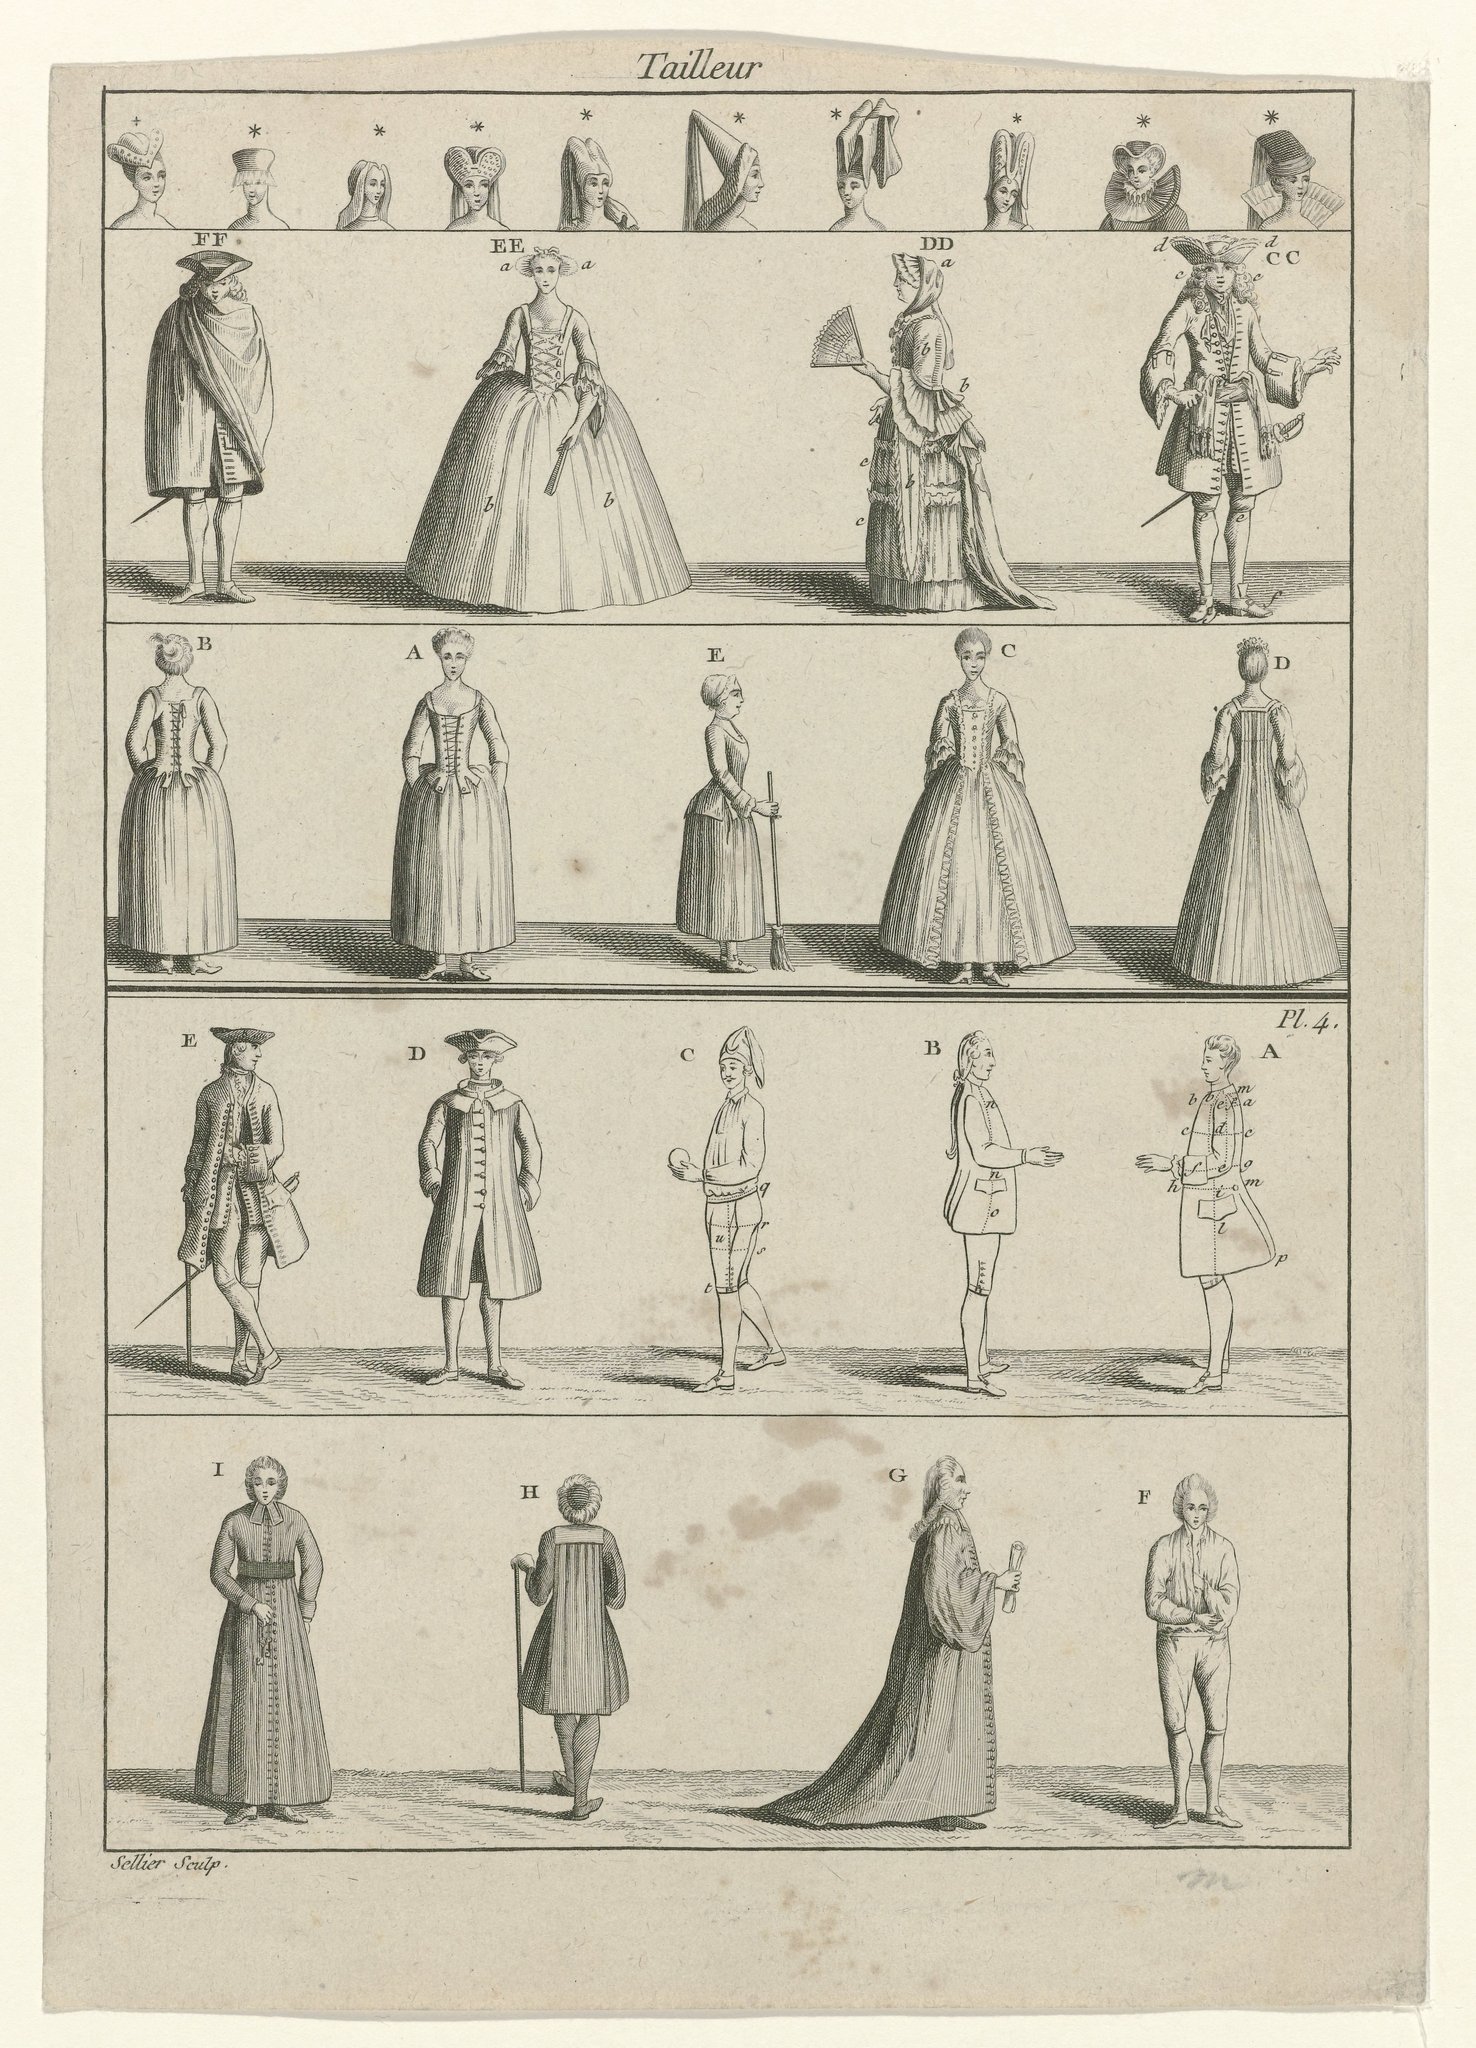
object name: costume print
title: Vrouwen- en mannenkleren uit verschillende periodes verdeeld in vijf kaders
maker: sellier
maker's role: printer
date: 1700-1799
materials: paper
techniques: engraving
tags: coat (justaucorps) (+ men's clothes), head-gear (+ women's clothes), head-gear: hat (+ men's clothes), fashion plates, clothes, costume (+ women's clothes), dress, gown (+ women's clothes), clothes, costume (+ men's clothes)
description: Verschillende staande figuren in vrouwen- en mannenkleren uit de 17de en 18de eeuw, verdeeld over vijf kaders. Van boven naar beneden: tien vrouwenhoofden met hoeden uit verschillende periodes, waaronder de late middeleeuwen. Twee mannen met mantel en justaucorps, twee vrouwen met waaiers. Vijf vrouwen genummerd A tot en met E. Vijf mannen genummerd A tot en met E. Vier mannen genummerd I, H, G en F.